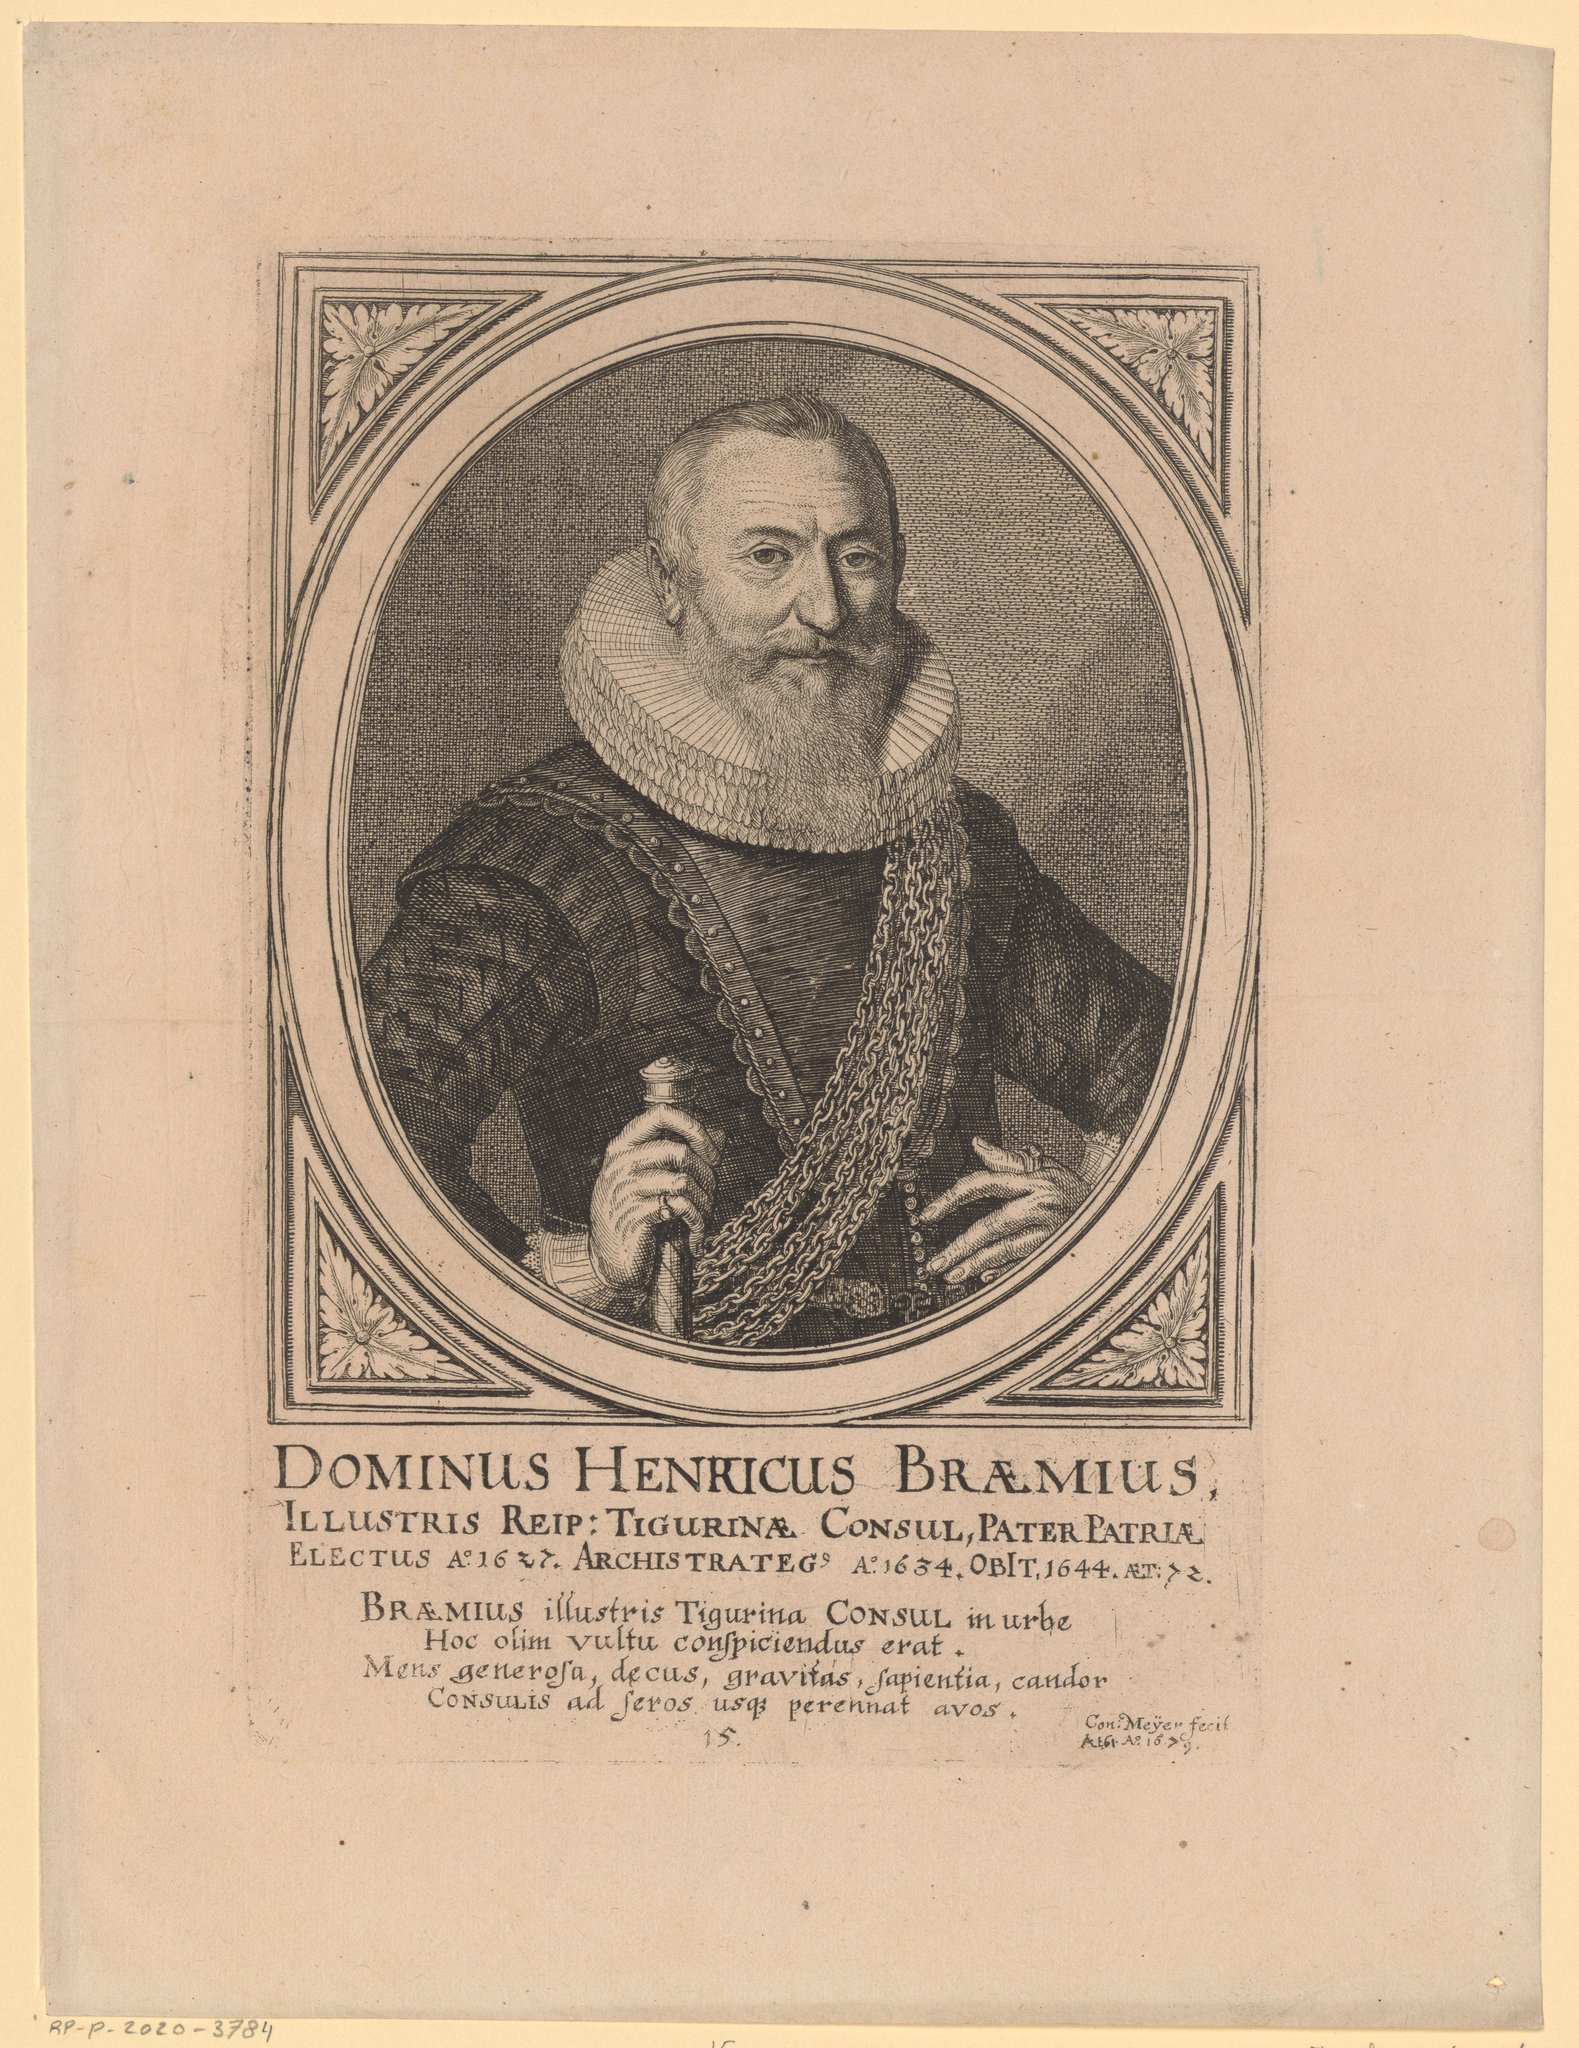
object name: print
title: Portretten van burgemeesters van Zürich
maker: conrad meyer (i)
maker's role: painter, print maker, publisher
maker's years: 1618-1689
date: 1679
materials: paper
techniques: engraving, etching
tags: mayor, mayor, burgomaster, historical persons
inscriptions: collector's mark: Lugt 2228